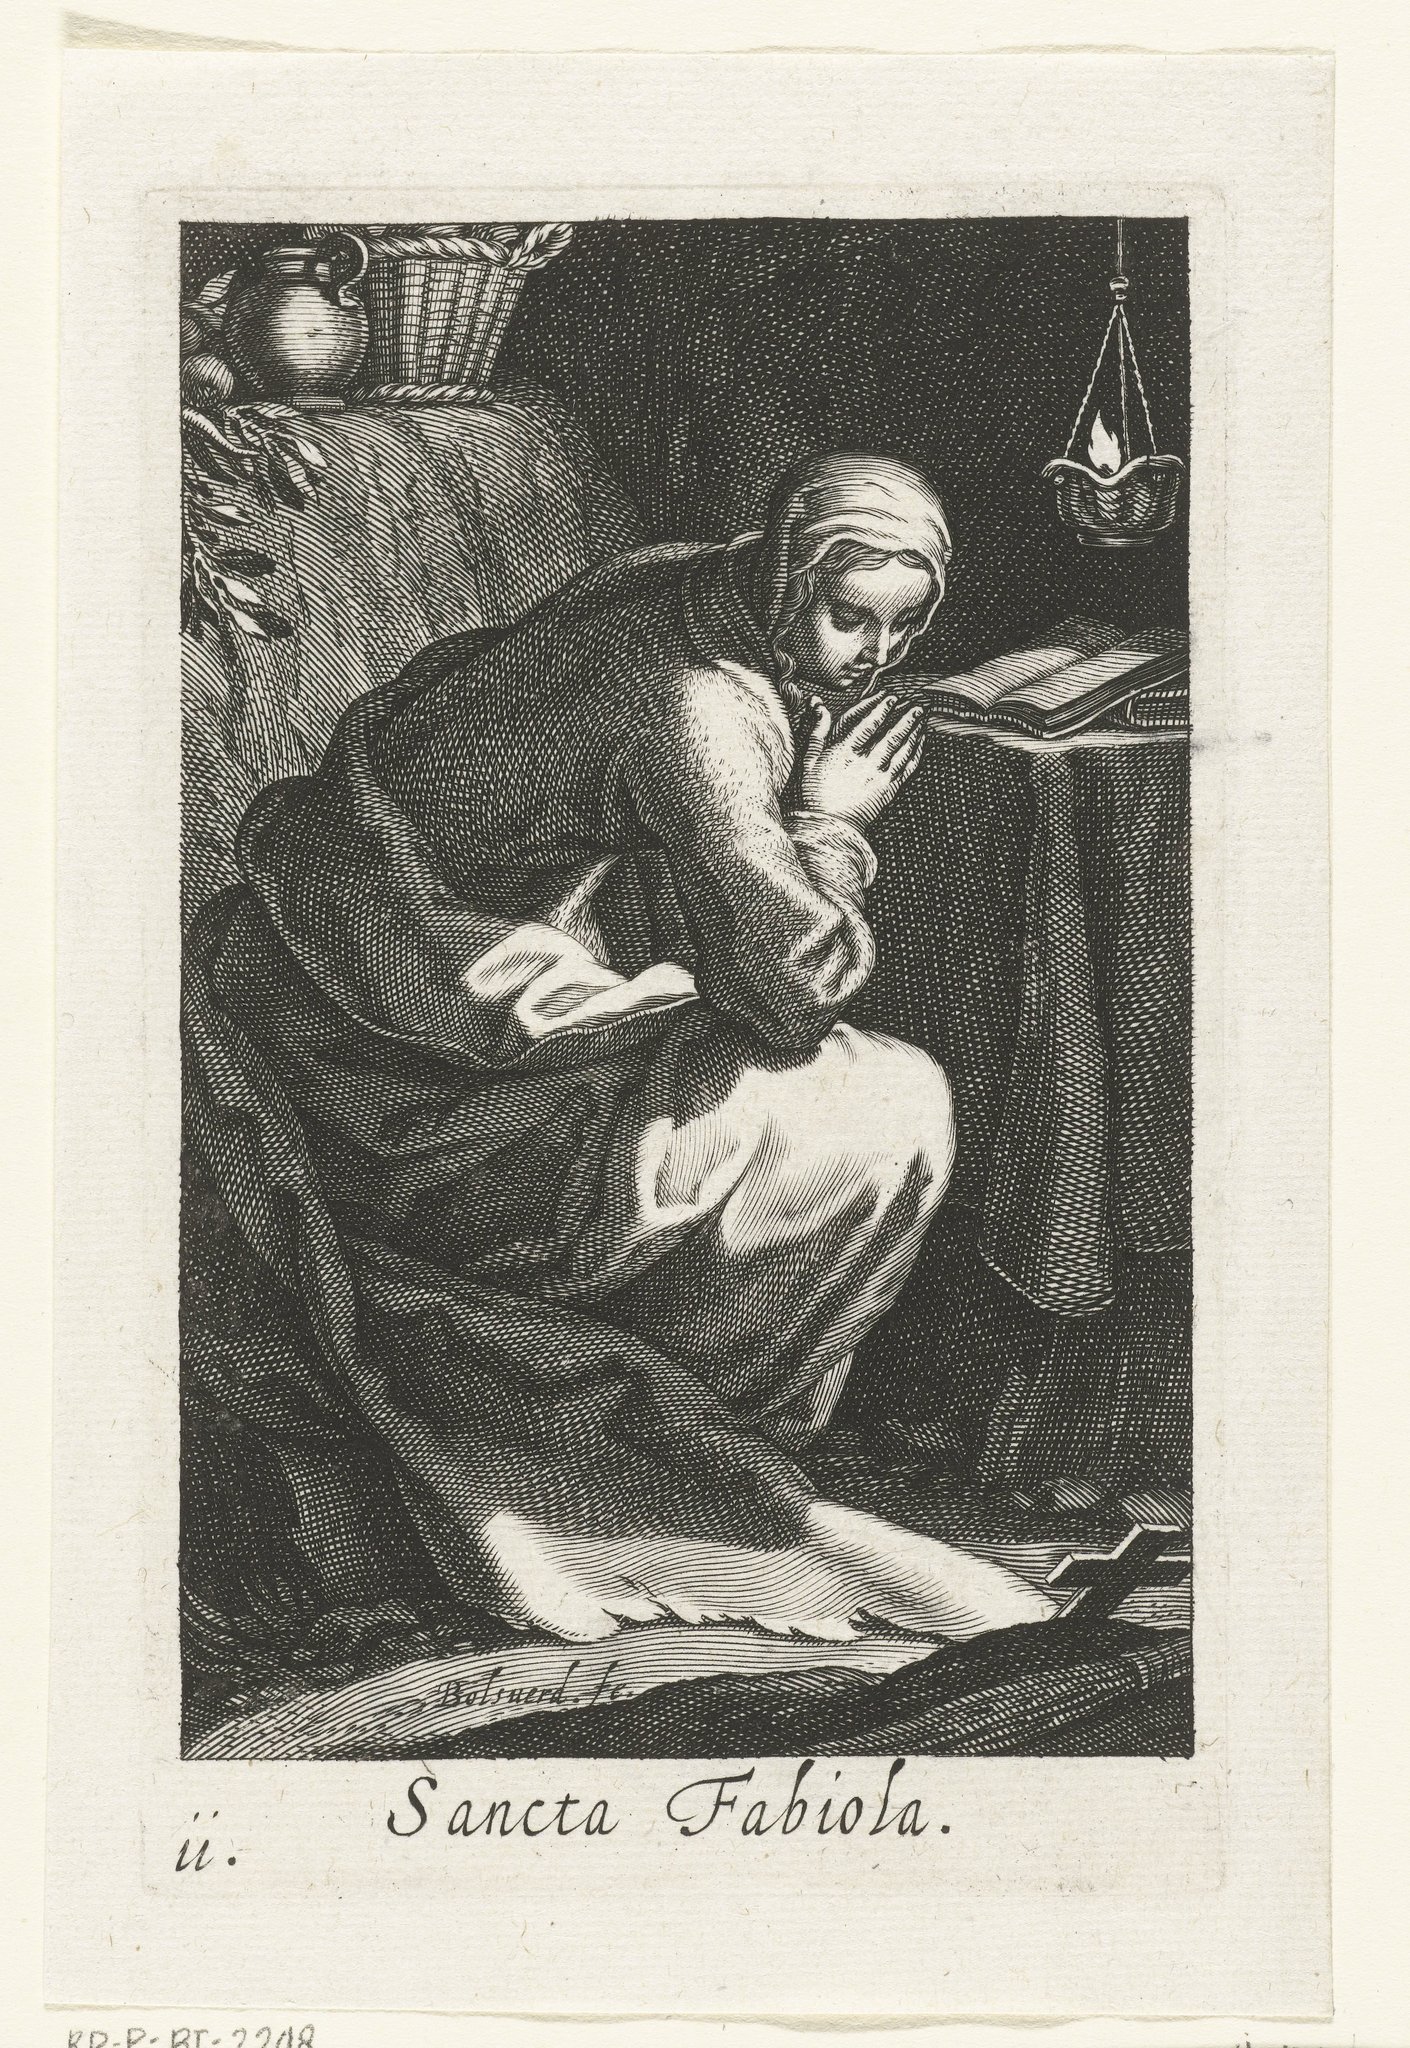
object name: print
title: Heilige Fabiola van Rome als kluizenares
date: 1590-1612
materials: paper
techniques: engraving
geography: antwerp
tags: anchorite, hermit, female saints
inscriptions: collector's mark: Lugt 2228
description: Prent uit: Sacra Eremus Ascetriarum, uitgever Boëtius Adamsz. Bolswert, 1612 of Hendrik Aertssen, Antwerpen 1619. Prent uit de serie van vijfentwintig kluizenaressen in deze uitgaven. In 1612 verscheen een ongebonden editie maar op basis van de gewijzigde opschriften en samenstelling van de serie kluizenaars wordt aangenomen dat de prenten van de uitgave 1619 ook in 1612 of iets daarvoor gedrukt werden. De serie kluizenaressen bleef vrijwel ongewijzigd in de ongebonden uitgave van 1612, dit compliceert de datering van de losse bladen in de collectie van het RMA, zie Roethlisberger 1993, p. 171-175.